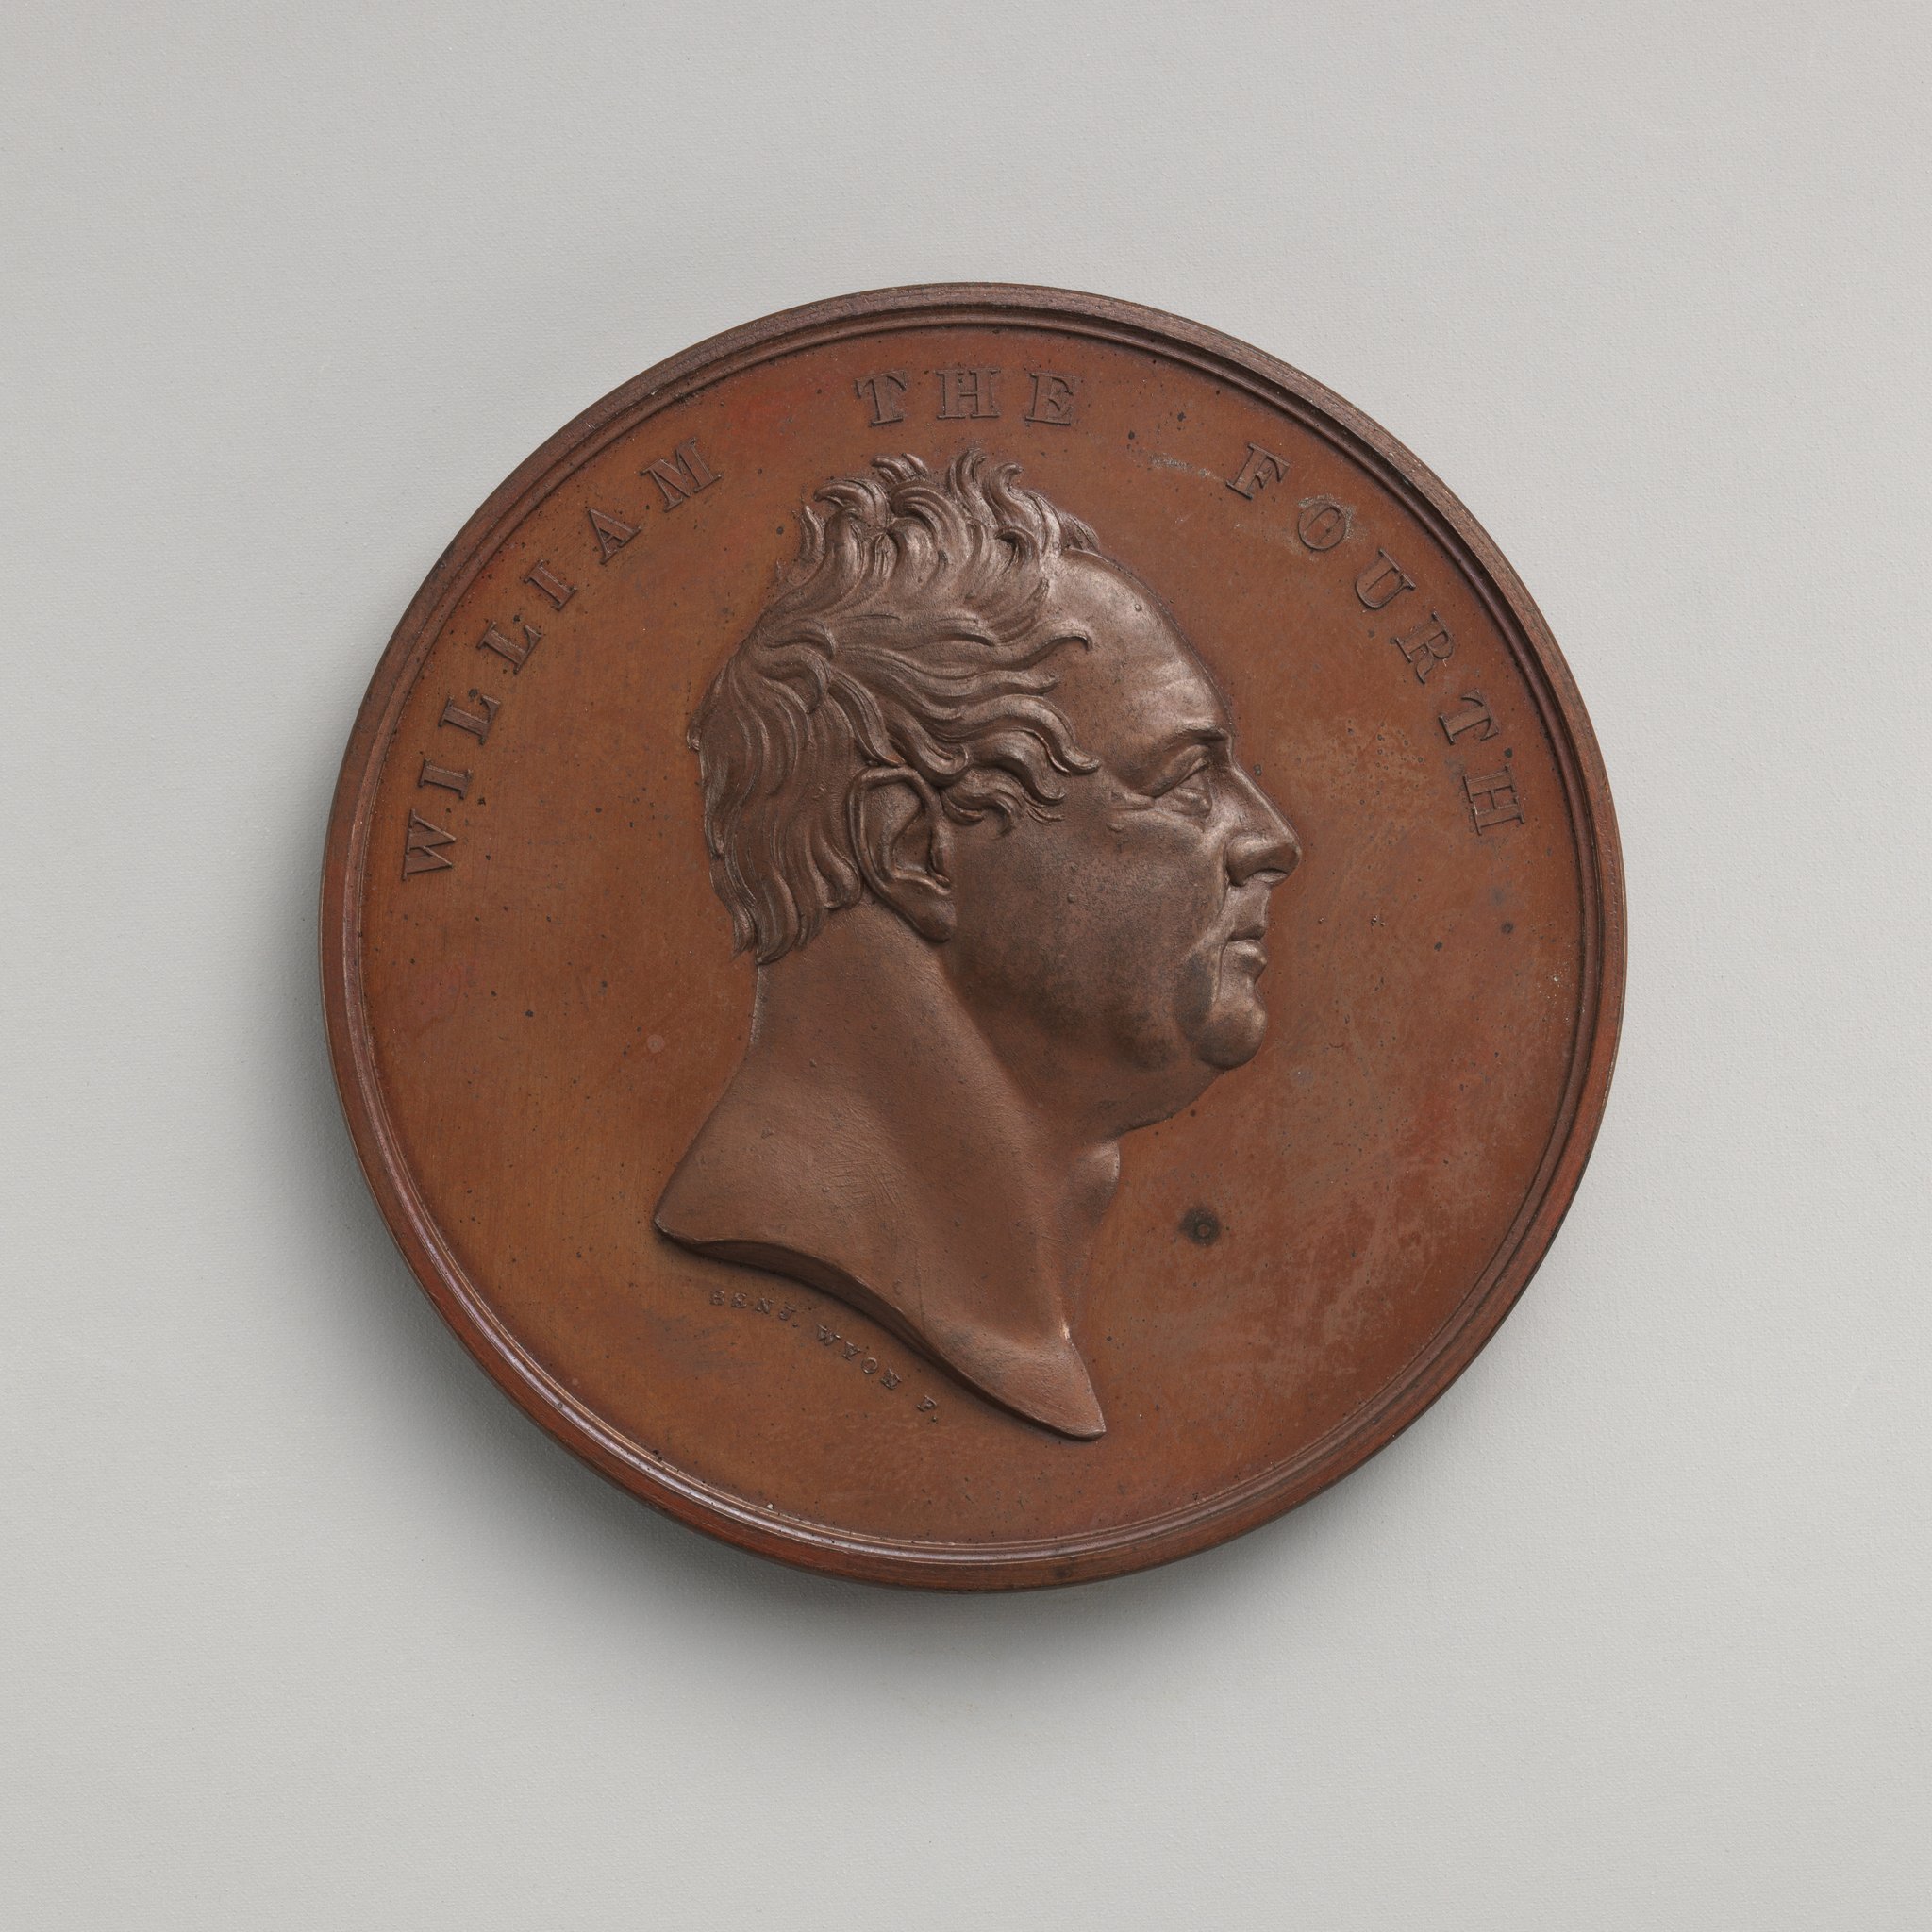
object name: medal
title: To Commemorate the Opening of the New London Bridge, by King William IV and Queen Adelaide, August 1, 1831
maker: benjamin wyon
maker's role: artist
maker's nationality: british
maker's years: 1802-1858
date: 1831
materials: bronze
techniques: struck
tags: bridges,kings,profiles